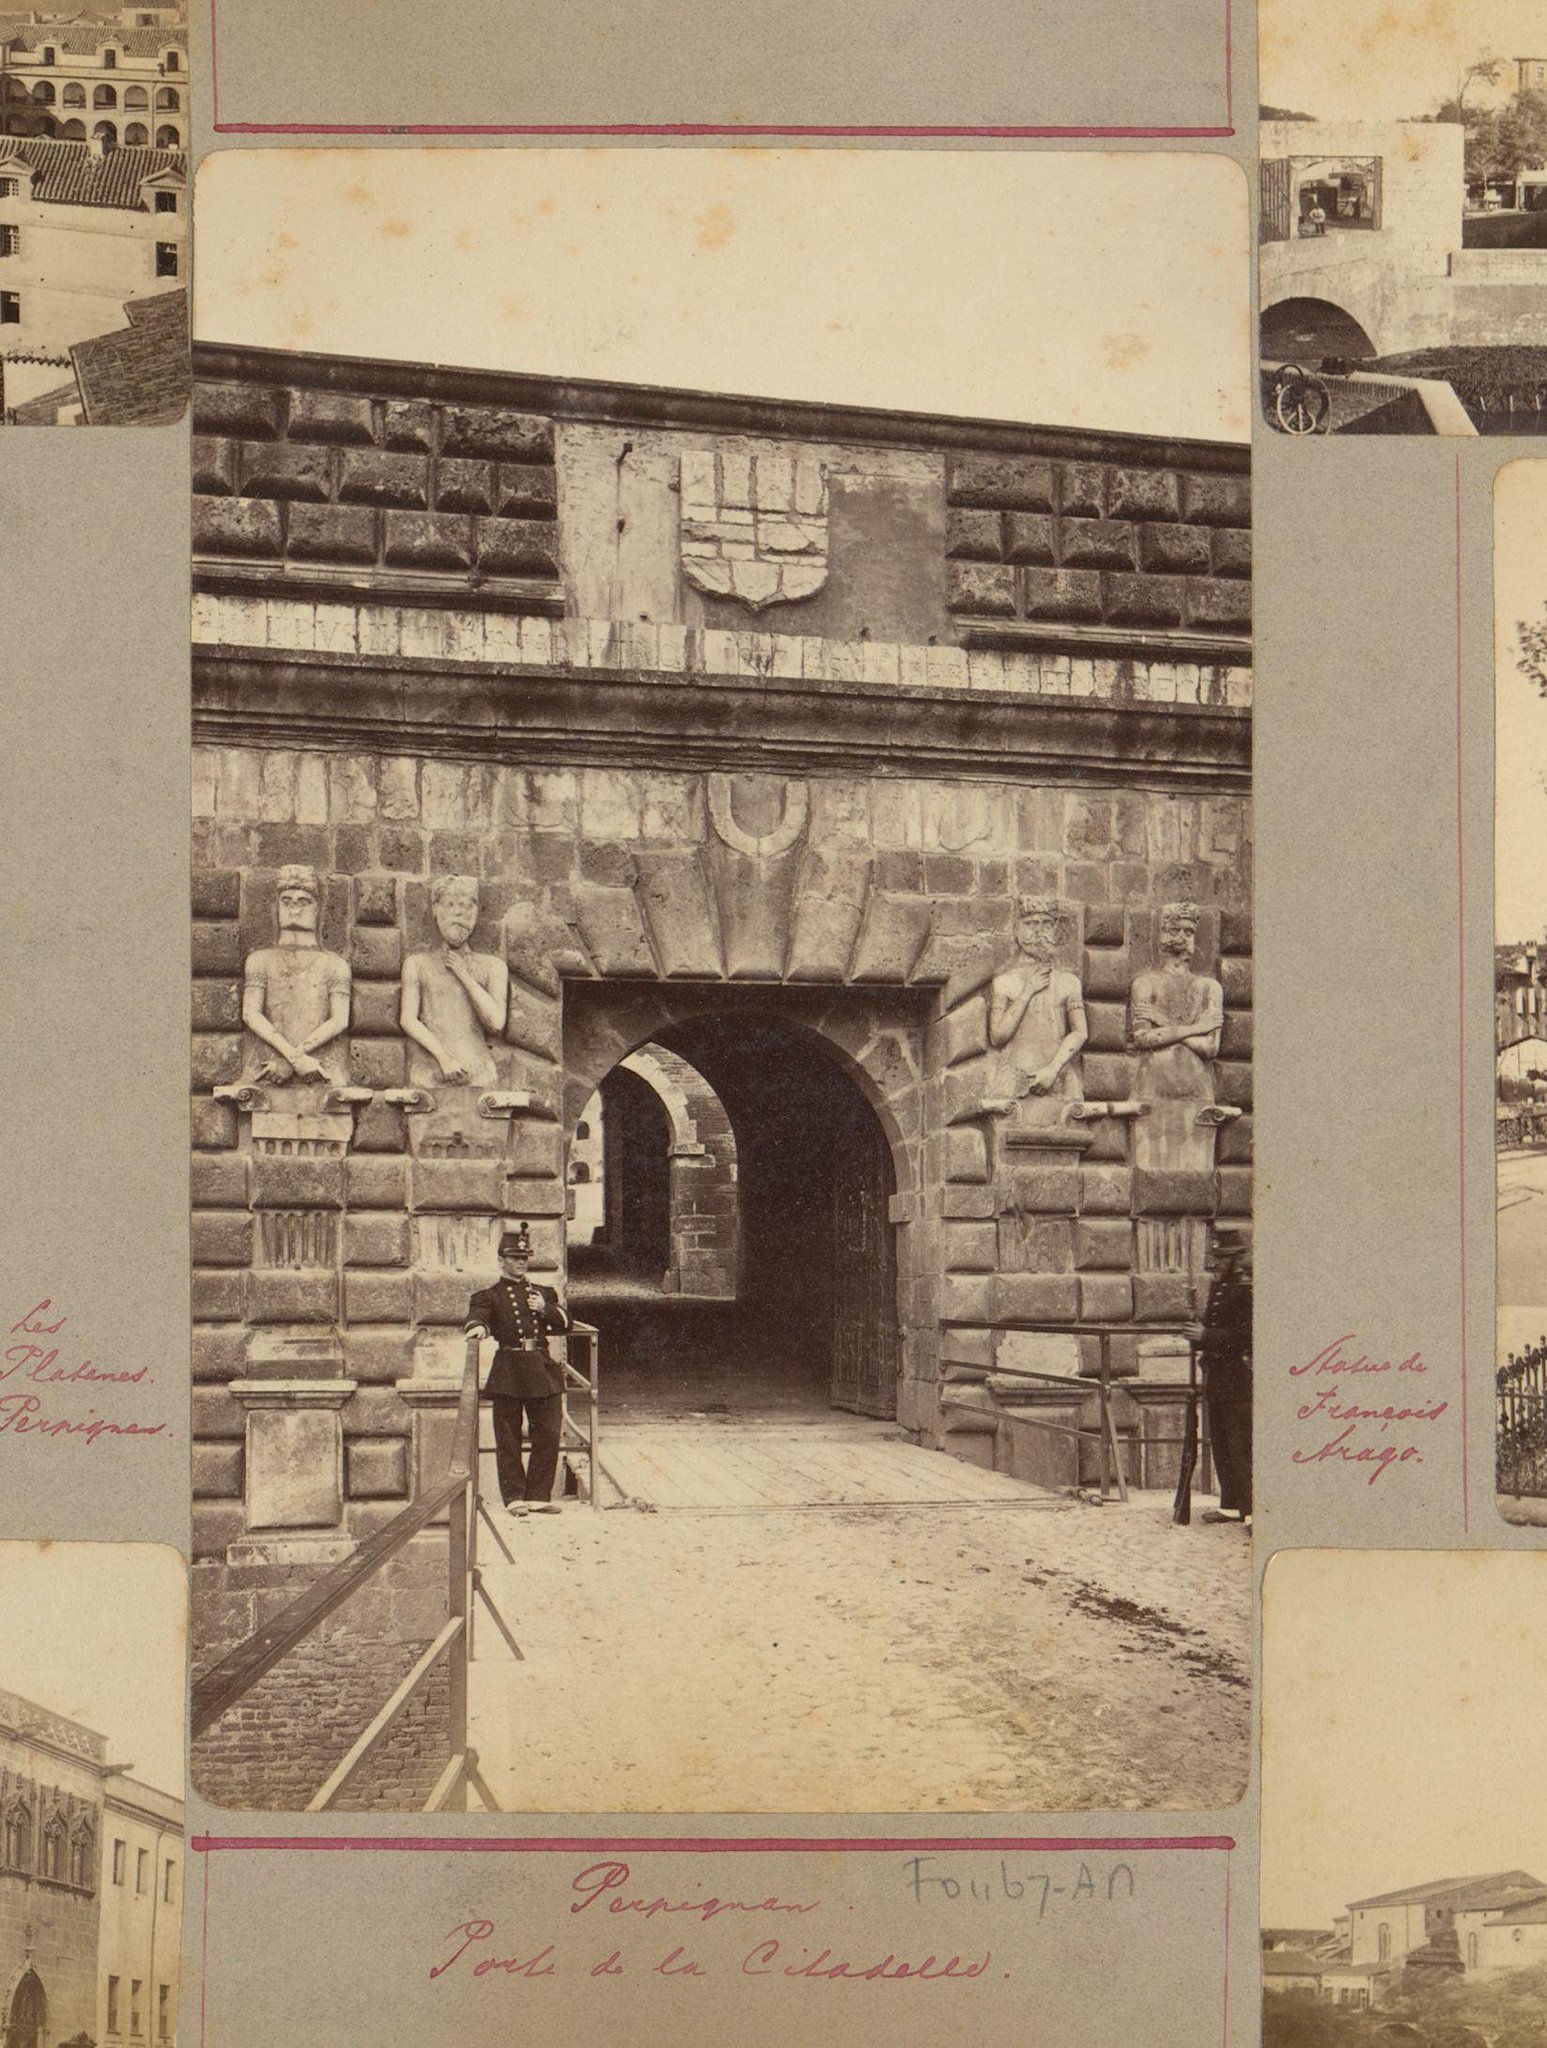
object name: photograph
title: Porte de la Citadelle te Perpignan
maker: Anonymous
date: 1880-1910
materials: photographic support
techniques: albumen print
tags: historical persons, city-gate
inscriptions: annotation: ‘Perpignan Porte de la Citadelle’